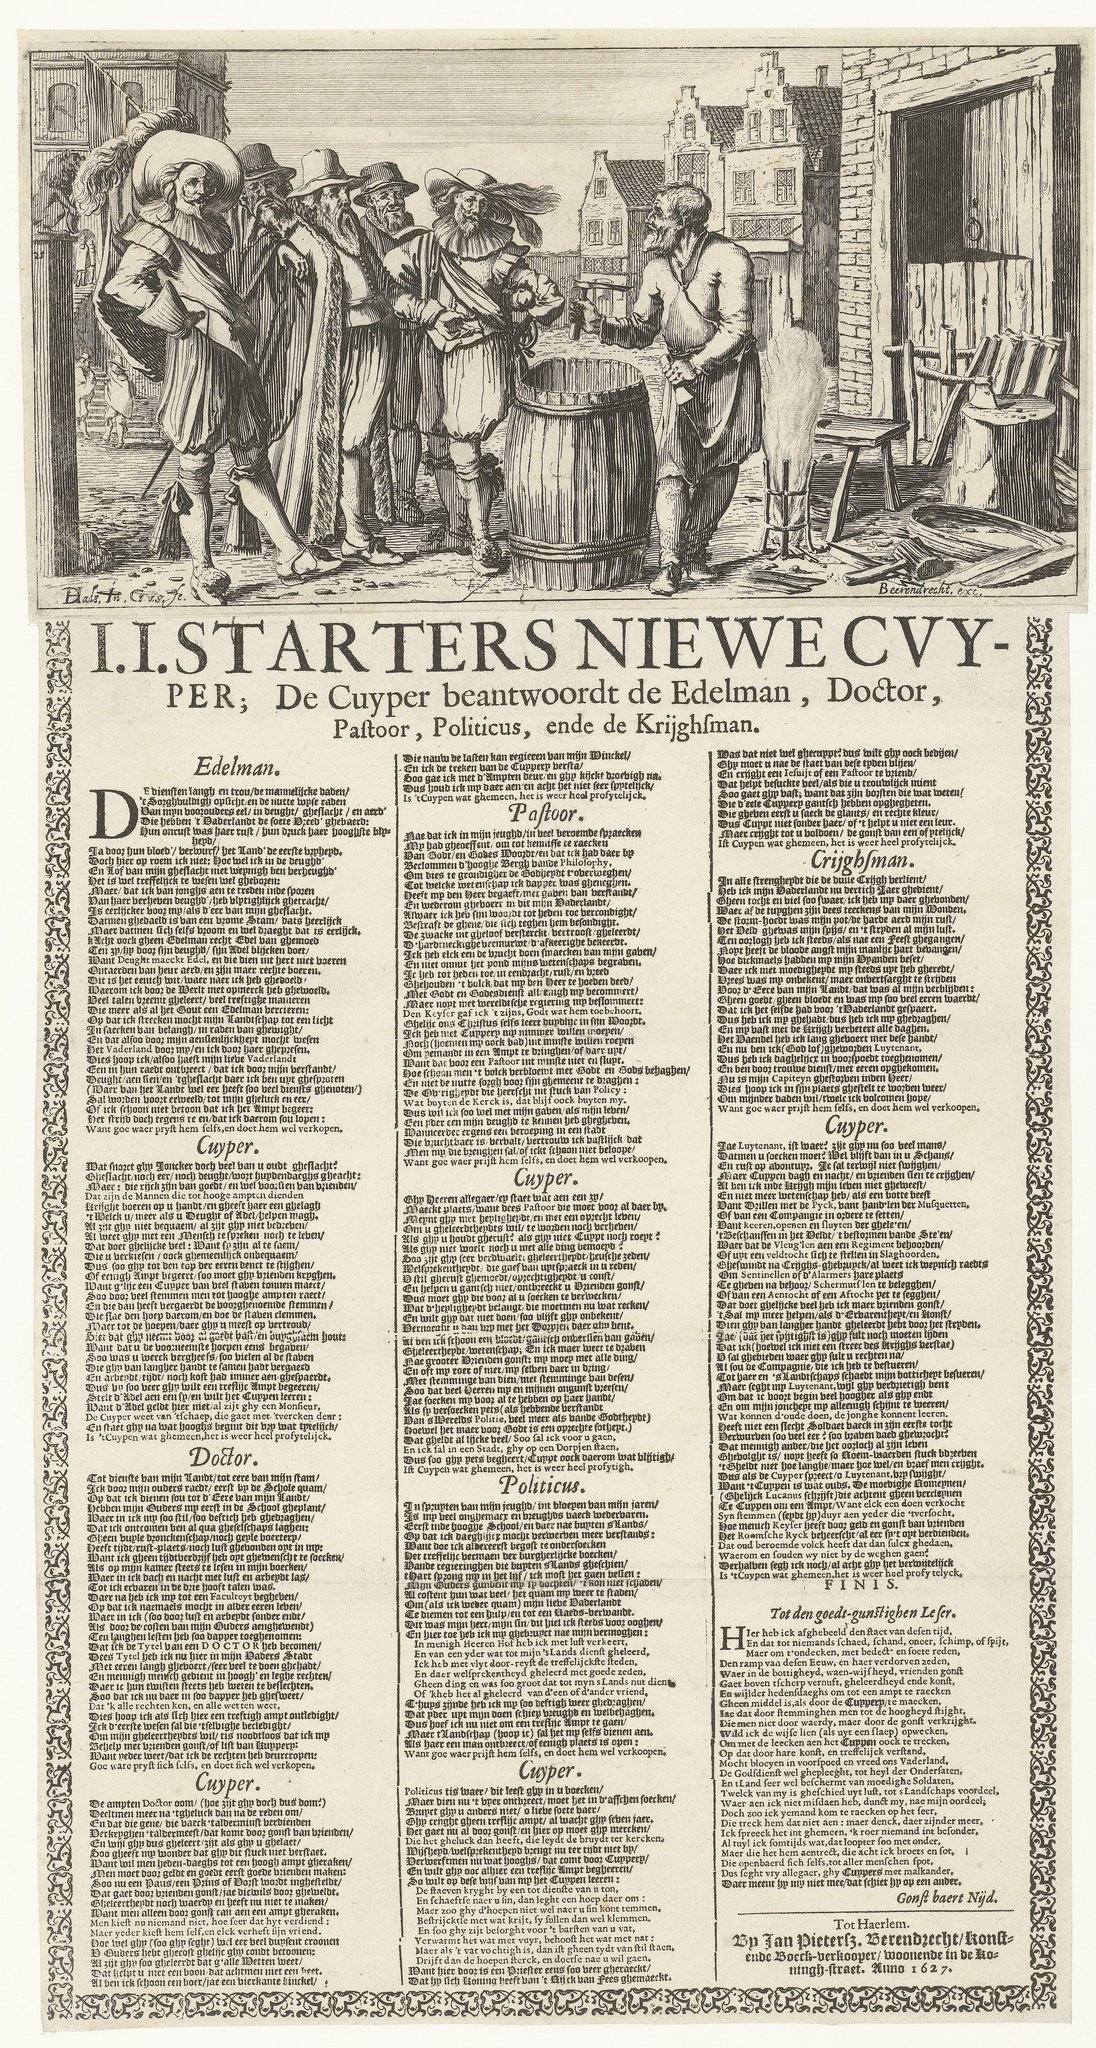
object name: print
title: Allegorie van de Nieuwe Kuiper, 1621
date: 1627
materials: paper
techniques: etching, letterpress printing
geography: northern netherlands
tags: wooden container: barrel, cask, bucket, other handicrafts ~ wood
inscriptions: date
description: Allegorische voorstelling van de Nieuwe Kuiper, 1621. Prent boven het gedicht Niewe Cuyper van J.J. Starter in 3 kolommen over de ambitie en eerzucht en de macht van de voorspraak in het verkrijgen van ambten in het jaar 1621. Een kuiper aan het werk spreekt met een edelman, doctor, pastoor, politicus en krijgsman.